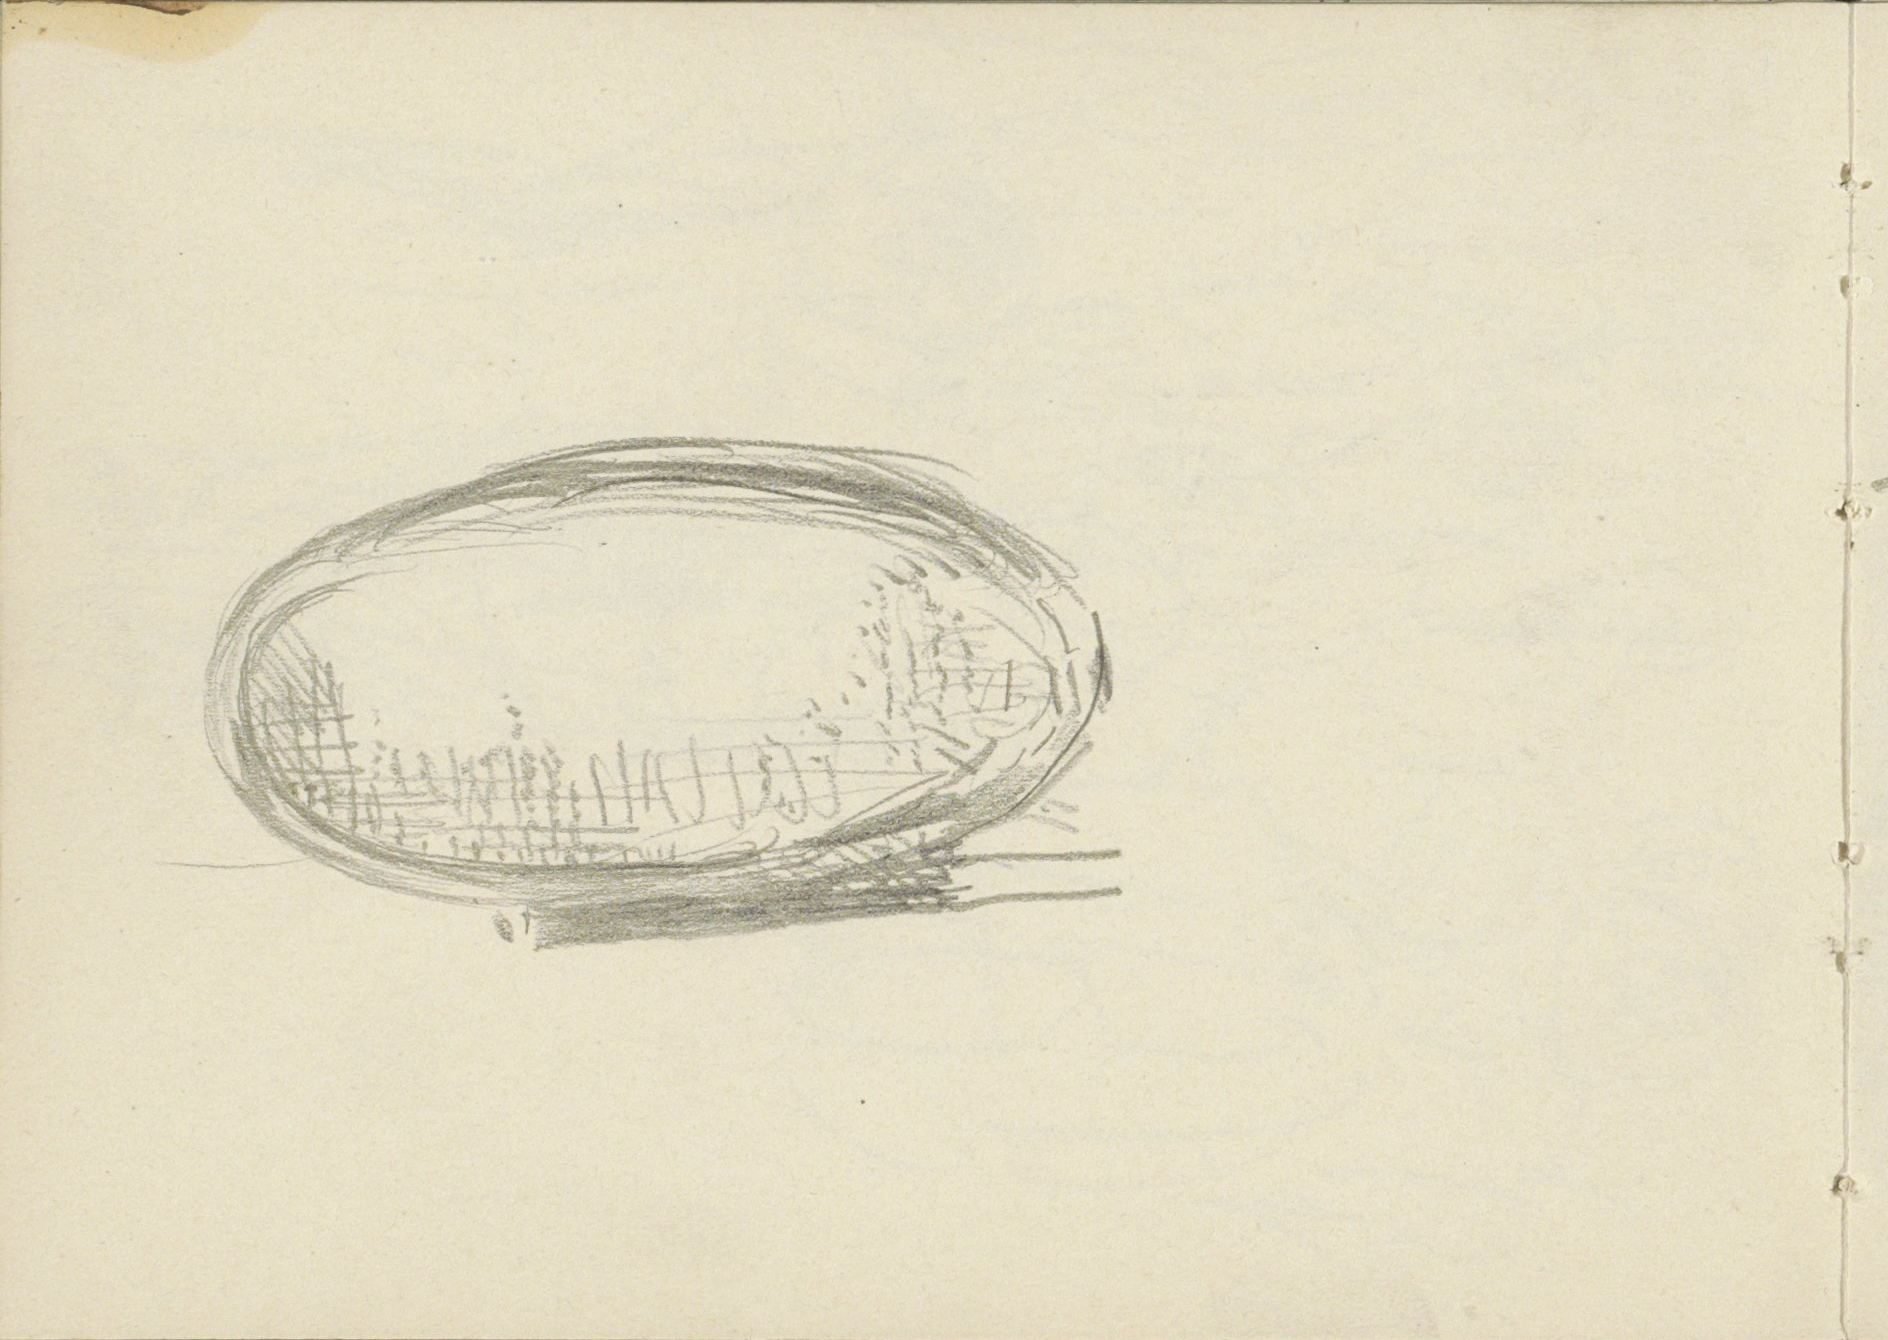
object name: sketchbook leaf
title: Ovaal voorwerp, mogelijk een schilderij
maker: isaac israels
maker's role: draughtsman, painter, print maker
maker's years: 1865-1934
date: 1930-1934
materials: paper, pencil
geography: the hague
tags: picture, painting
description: Pagina 7 uit schetsboek XXXVIII met 45 pagina's.